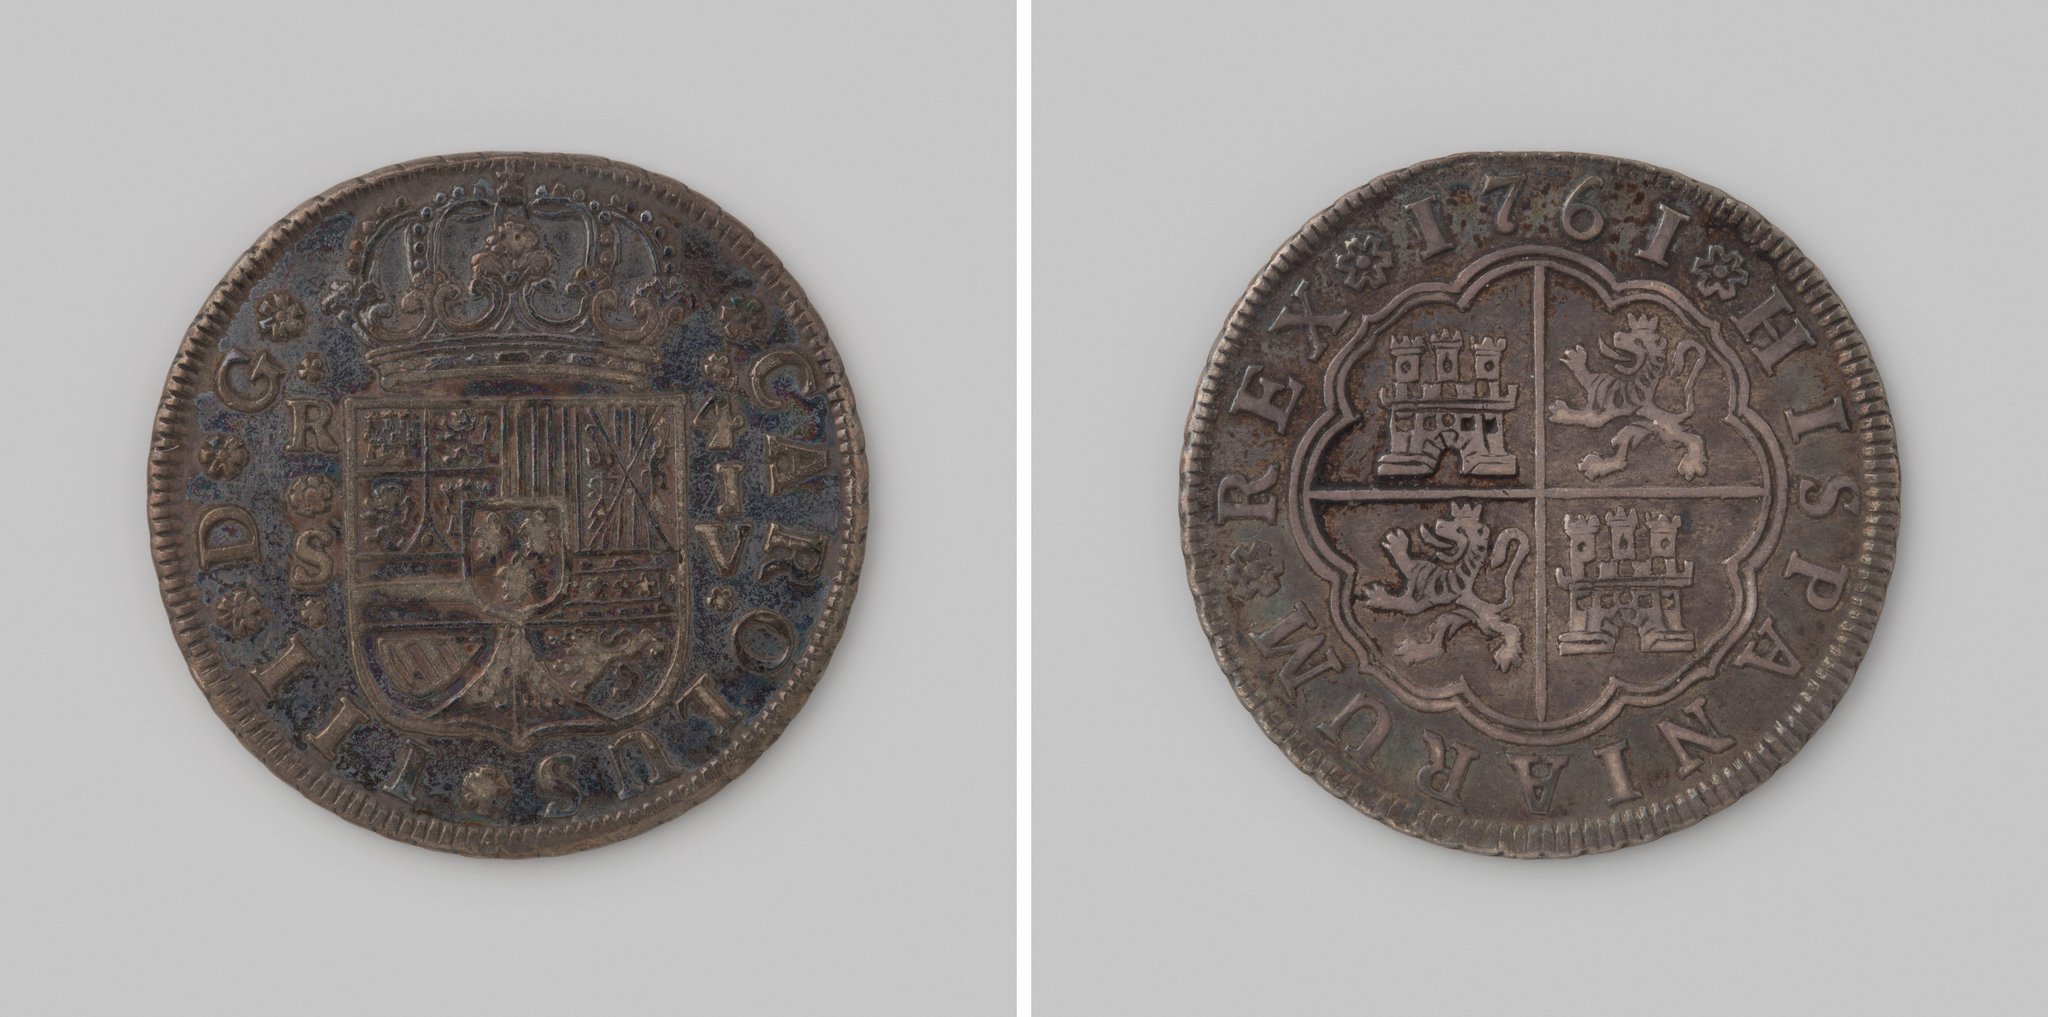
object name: vier reaal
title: Vier reaal uit Spanje van koning Karel III, 1761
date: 1761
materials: silver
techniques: striking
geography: sevilla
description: Zilveren munt. Voorzijde: gekroond samengesteld wapenschild. Rechts daarvan waarde-aanduiding: 4, links daarvan letter S [= Sevilla]. Keerzijde: binnen veelpas kort kruis met in de hoeken afwisselend een leeuw [=Leon] en een kasteel [=Castilië]. Jaartal bovenaan in omschrift. Bloemrand.